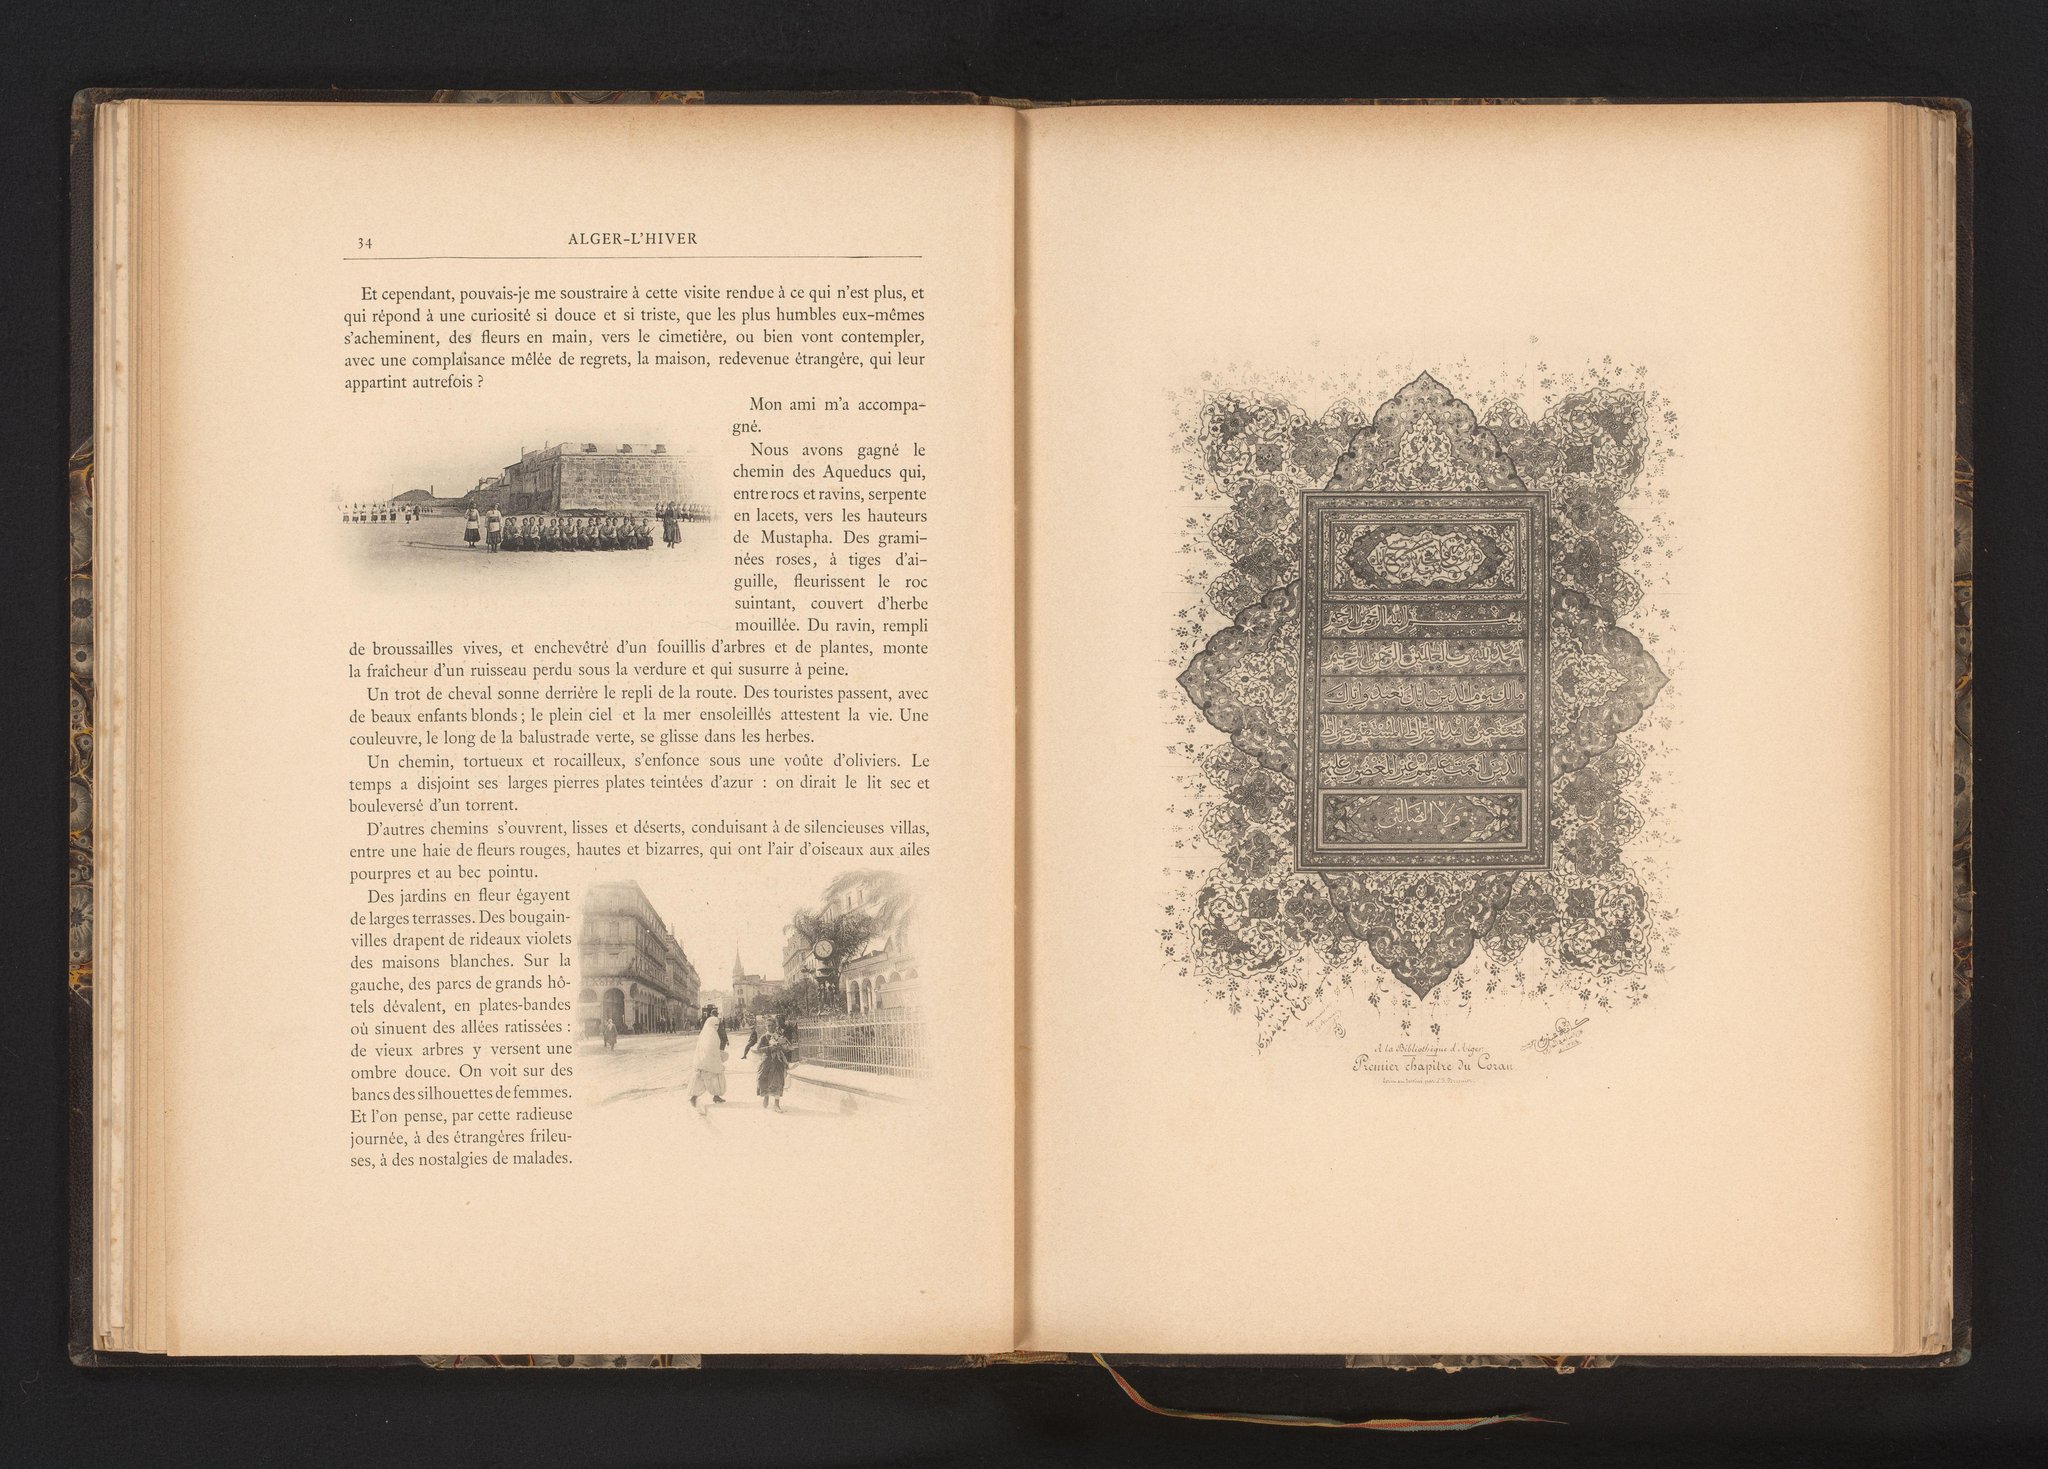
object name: photomechanical print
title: Mensen op straat in Algiers, Algerije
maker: jules gervais-courtellemont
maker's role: fotograaf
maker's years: 1863-1931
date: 1888-1893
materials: paper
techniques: photograph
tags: adult woman, youth, adolescent, street